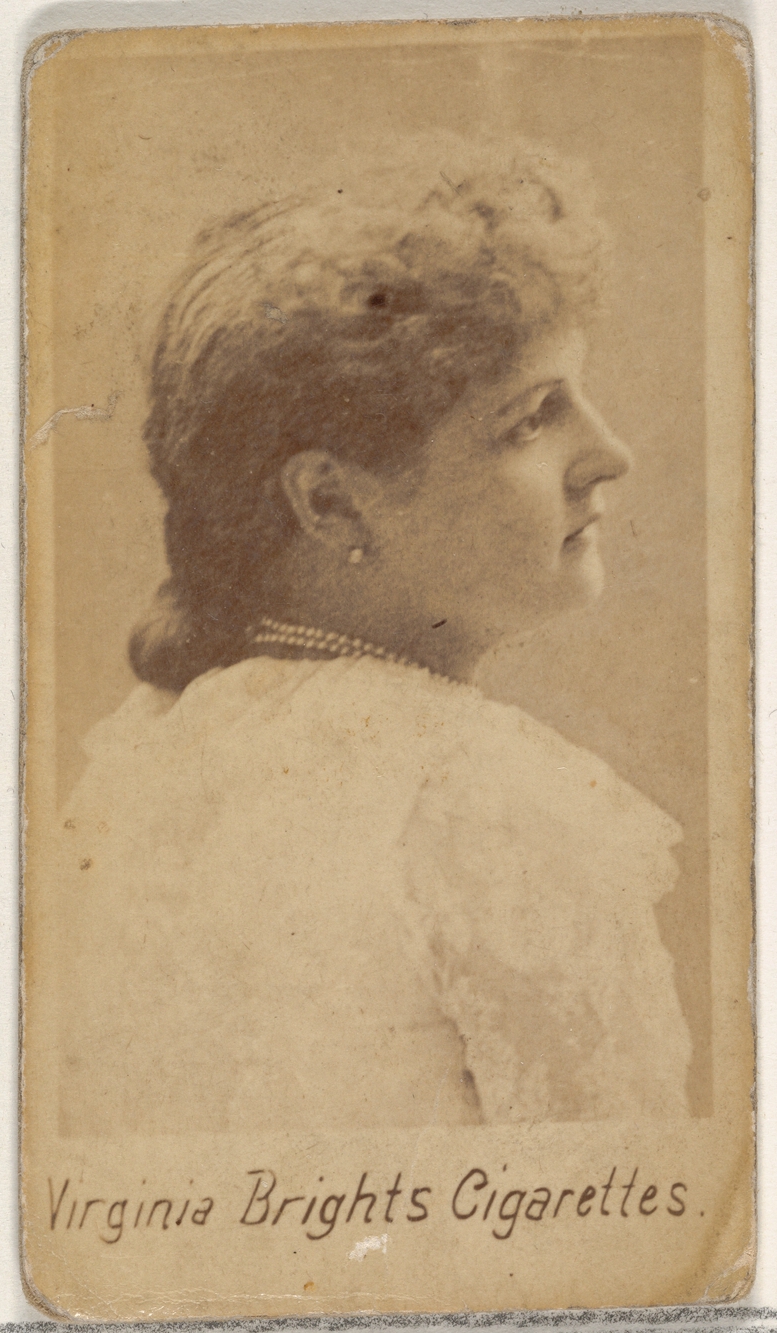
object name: photograph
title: From the Actors and Actresses series (N45, Type 5) for Virginia Brights Cigarettes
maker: allen & ginter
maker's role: publisher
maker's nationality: american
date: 1888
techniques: albumen silver print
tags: portraits,women,actresses